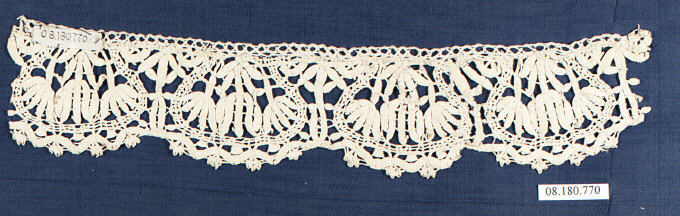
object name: piece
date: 1601-1700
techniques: lace